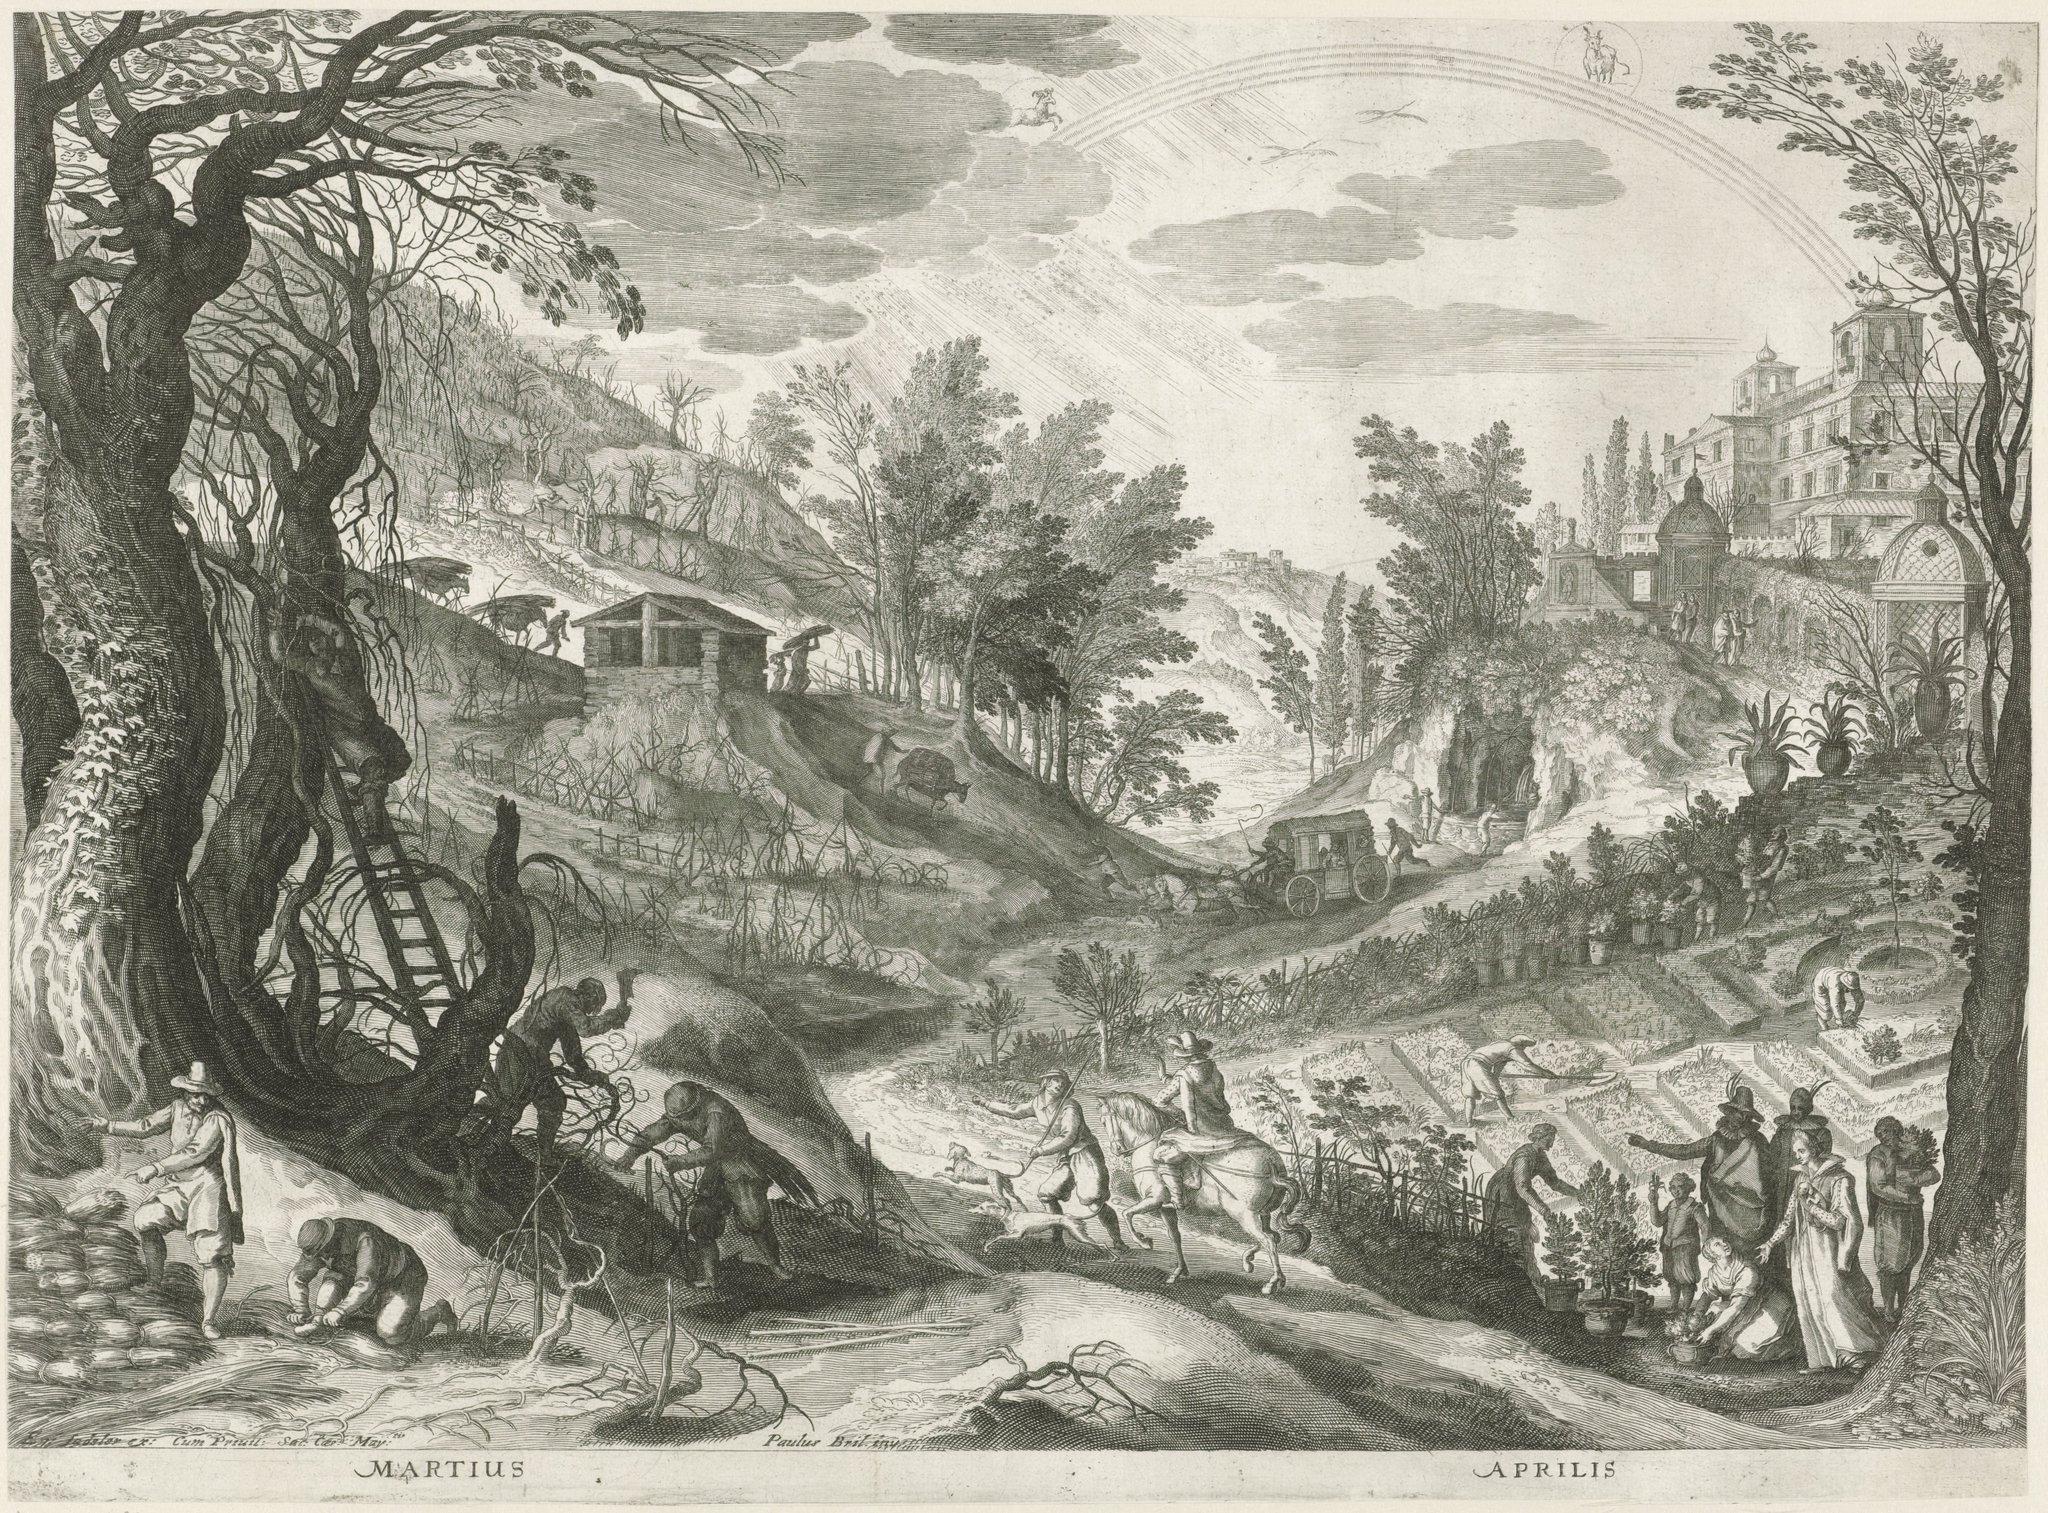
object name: print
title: Maart en april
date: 1615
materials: paper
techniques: engraving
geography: prague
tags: landscape symbolizing april (+ with zodiacal signs), woodgathering, woodgatherer, castle, woodcutting, woodcutter ~ forestry, gardening, march and its 'labours' (+ with zodiacal signs), june and its 'labours' (+ with zodiacal signs), landscape symbolizing march (+ with zodiacal signs)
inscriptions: collector's mark: Lugt 240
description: Heuvelachtig landschap met links het hakken en sprokkelen van hout en rechts het onderhoud van een tuin. Rechtsachter, tegen een heuvel, een paleis en tuin met pergola. Linksonder 'Martius', rechtsonder 'Aprilis'. Bovenaan de tekens van de zodiac: steenbok (links) en ram (rechts)